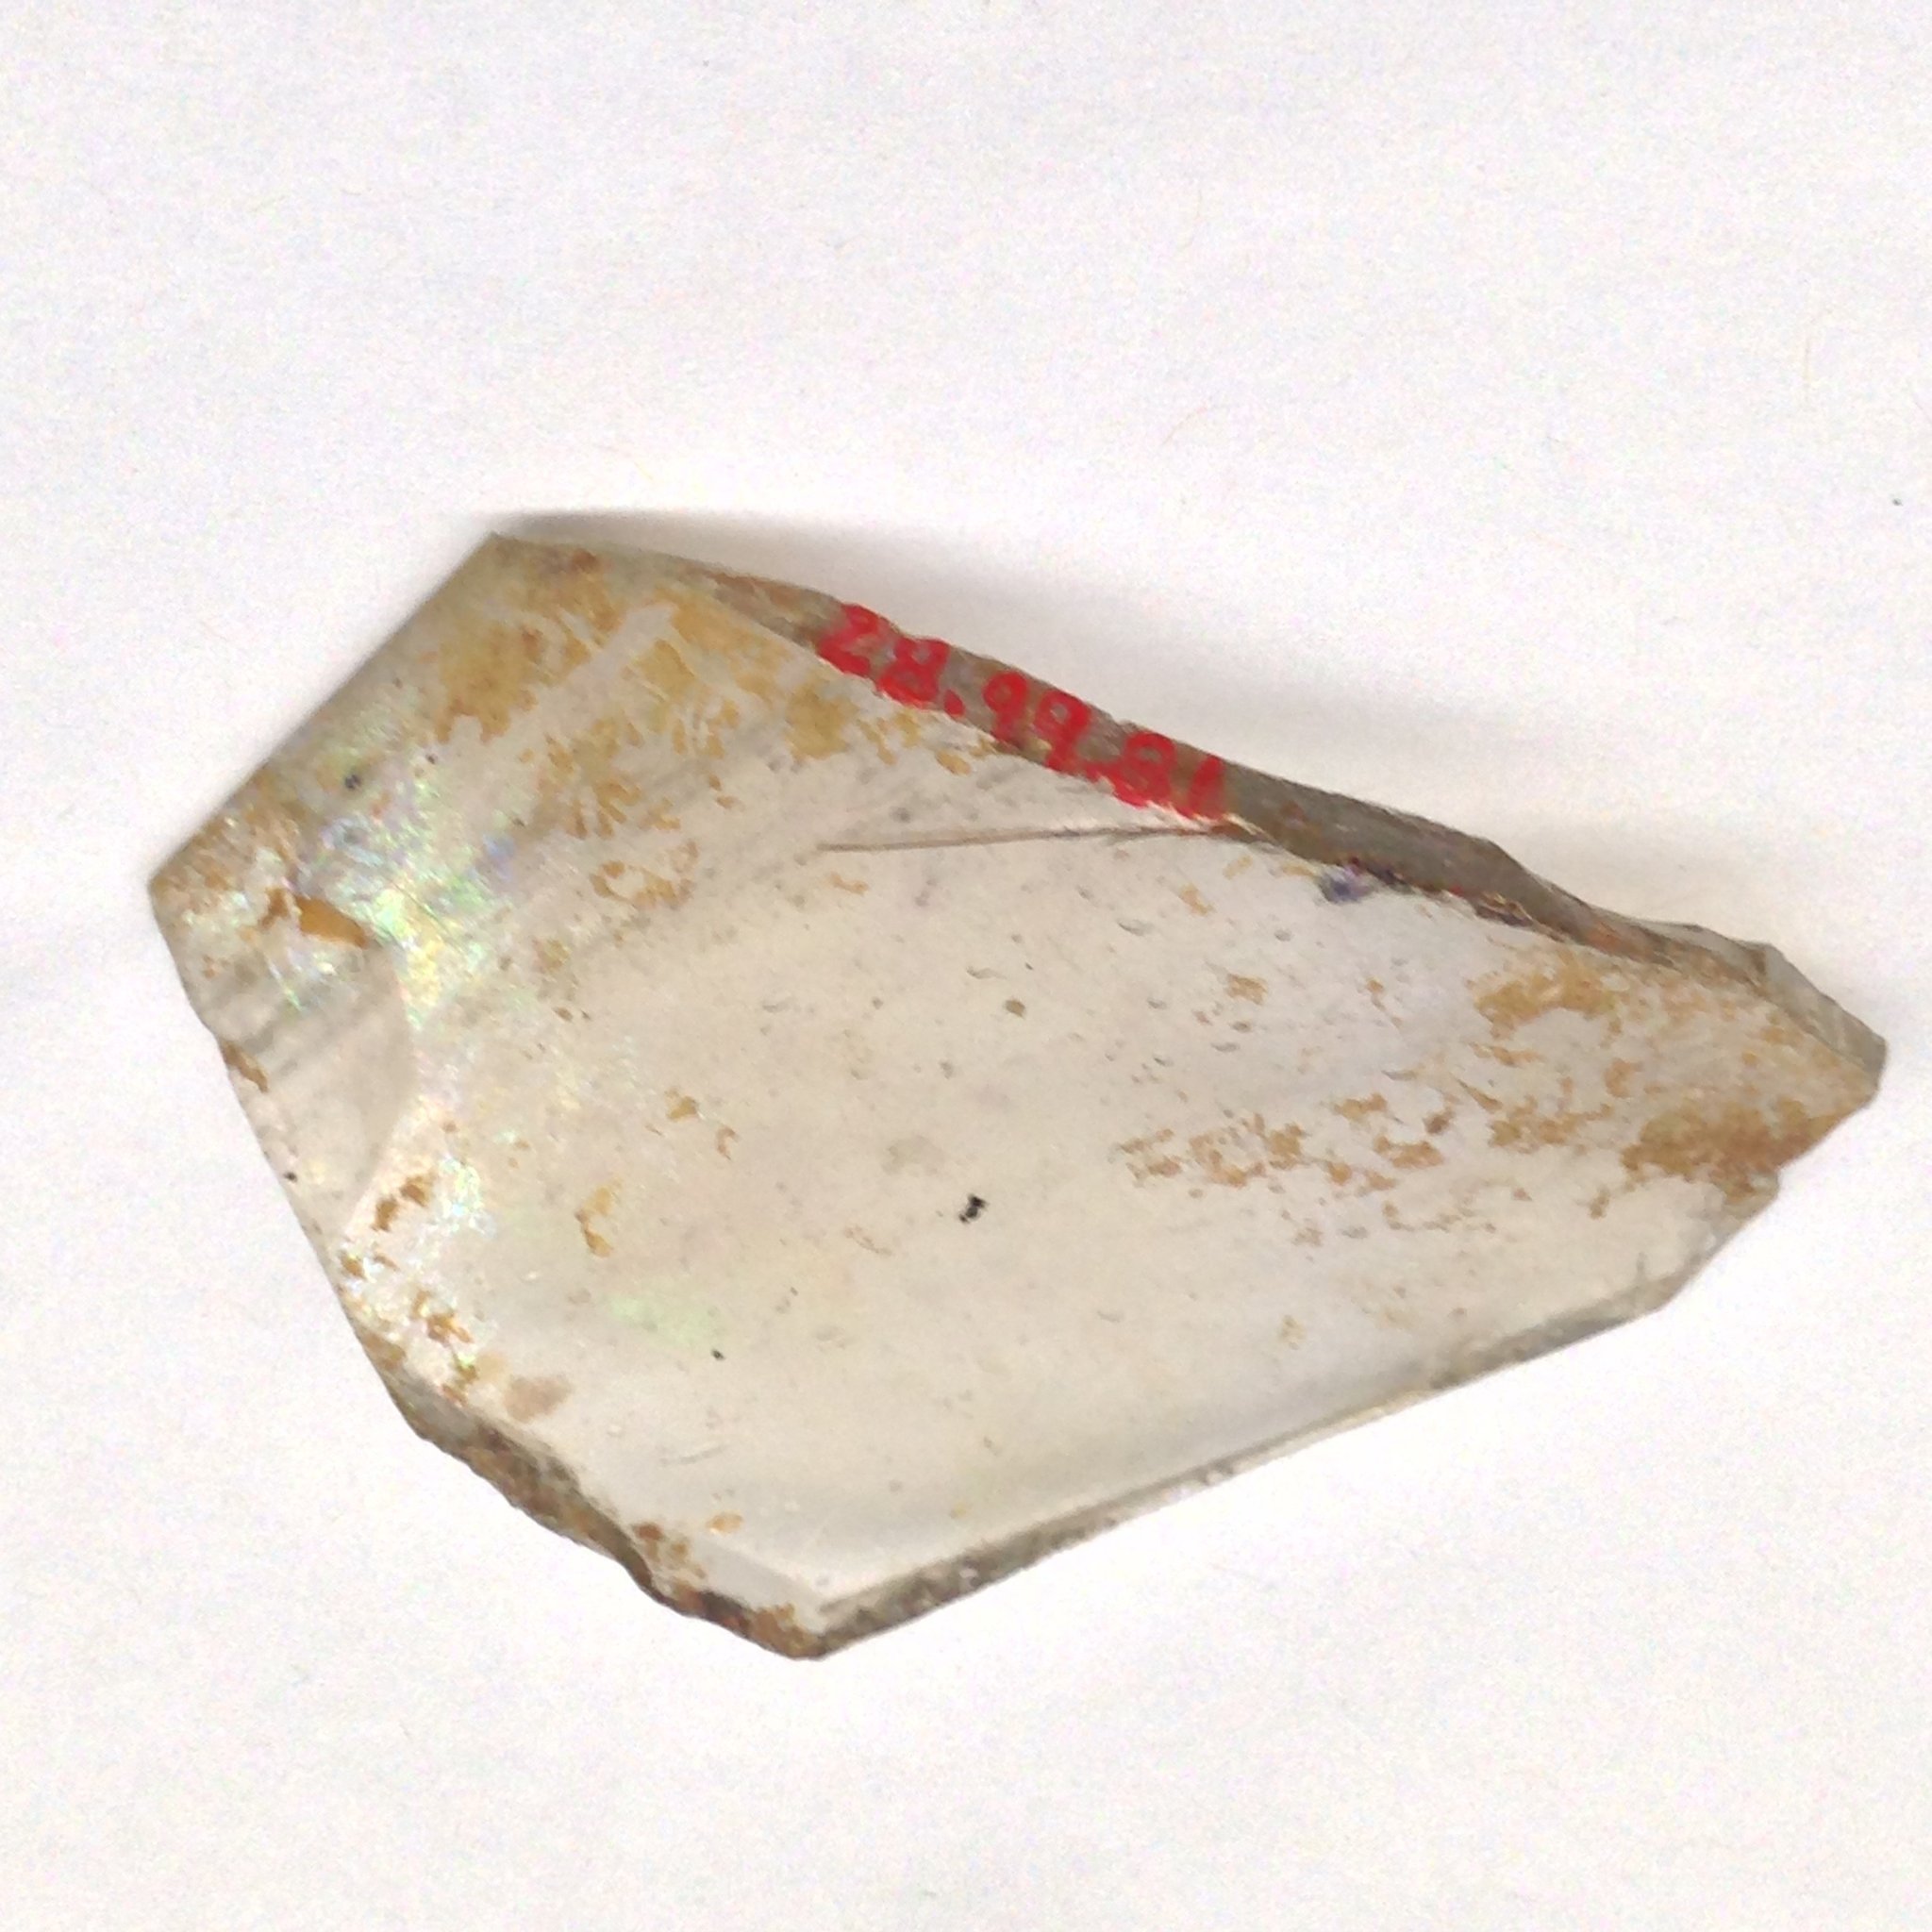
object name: fragment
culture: european or middle eastern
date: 1150-1250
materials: ceramic, glass